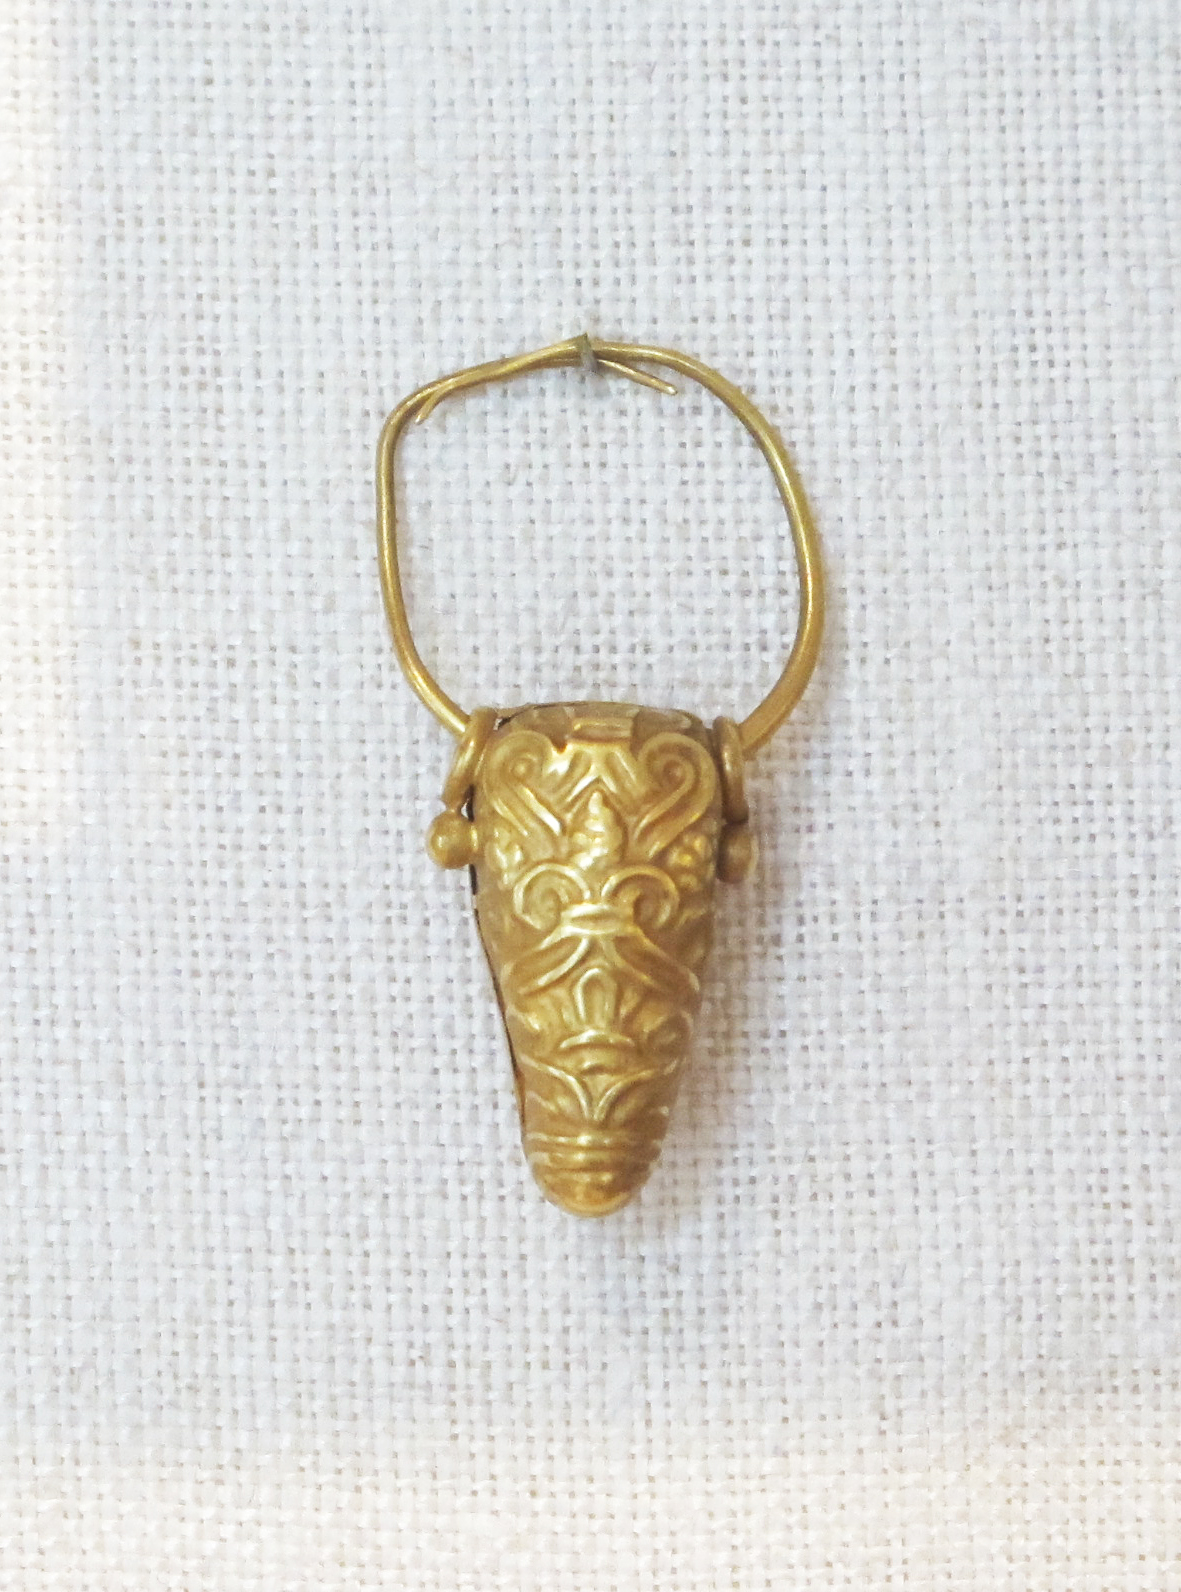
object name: earring with head of bull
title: Gold pendant in the form of a bull's head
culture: cypriot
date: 1400-1050 BCE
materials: gold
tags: bulls